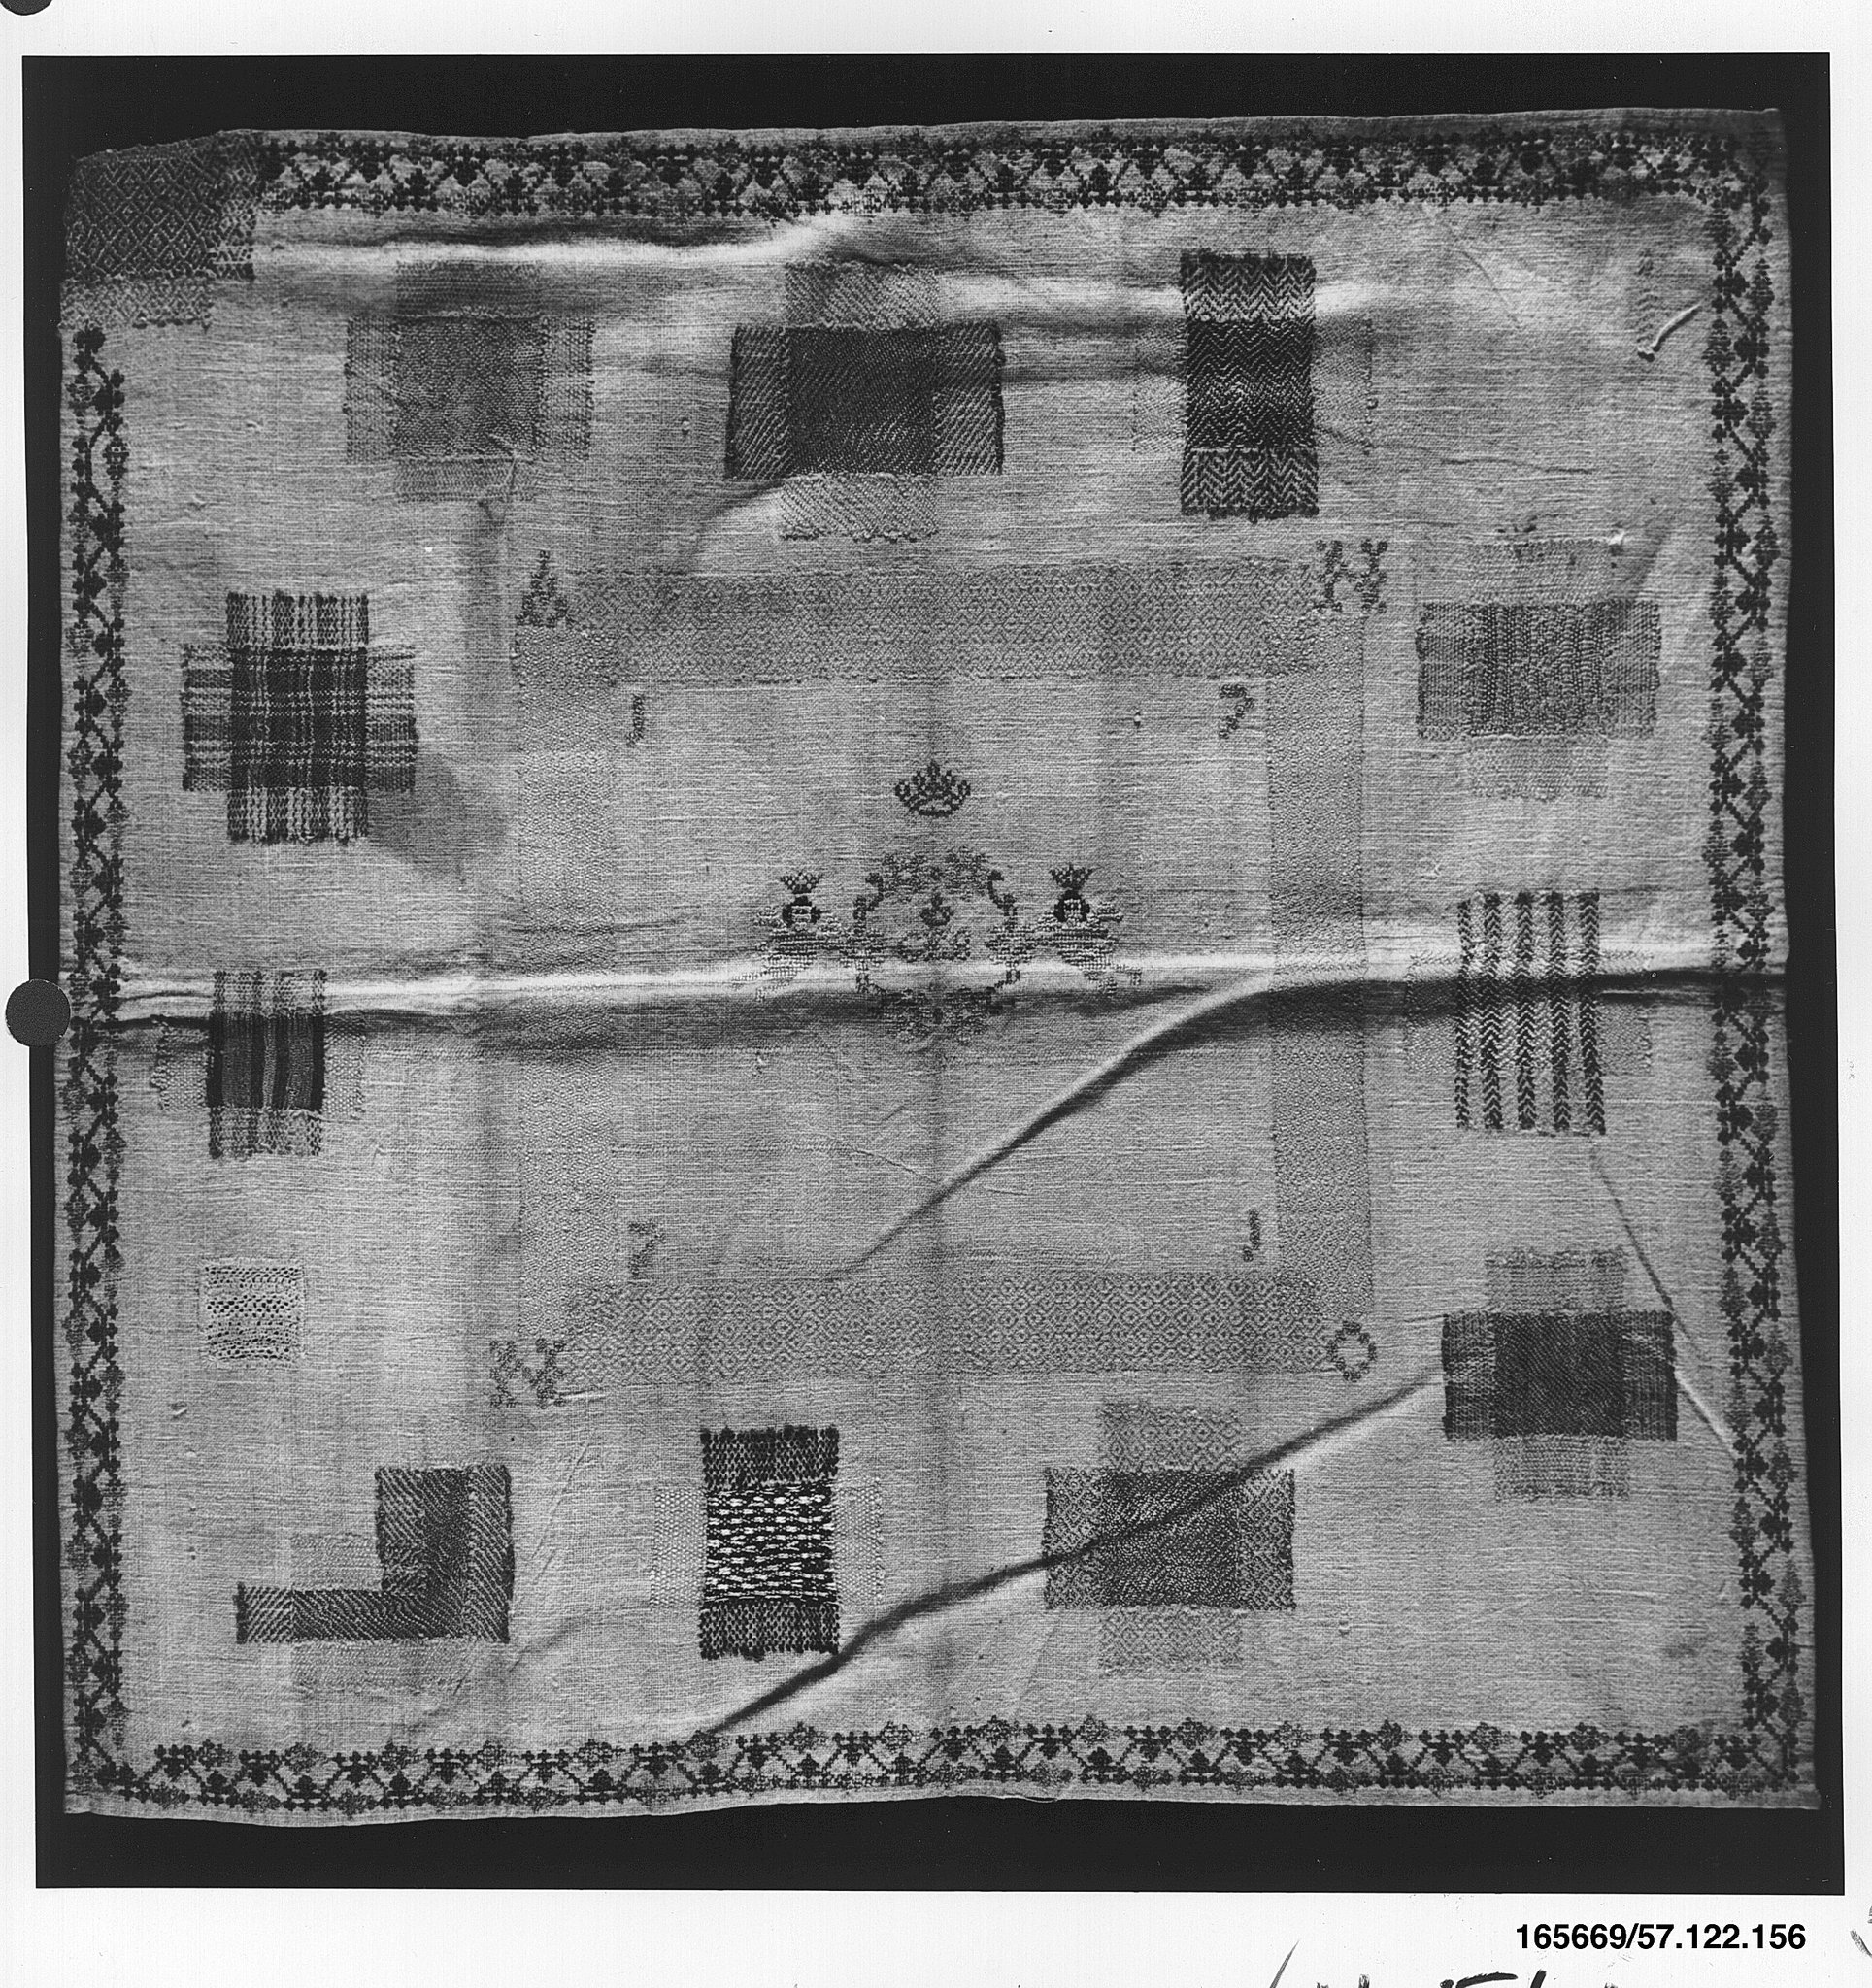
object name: sampler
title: Embroidered darning sampler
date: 1771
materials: cotton, silk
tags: coat of arms